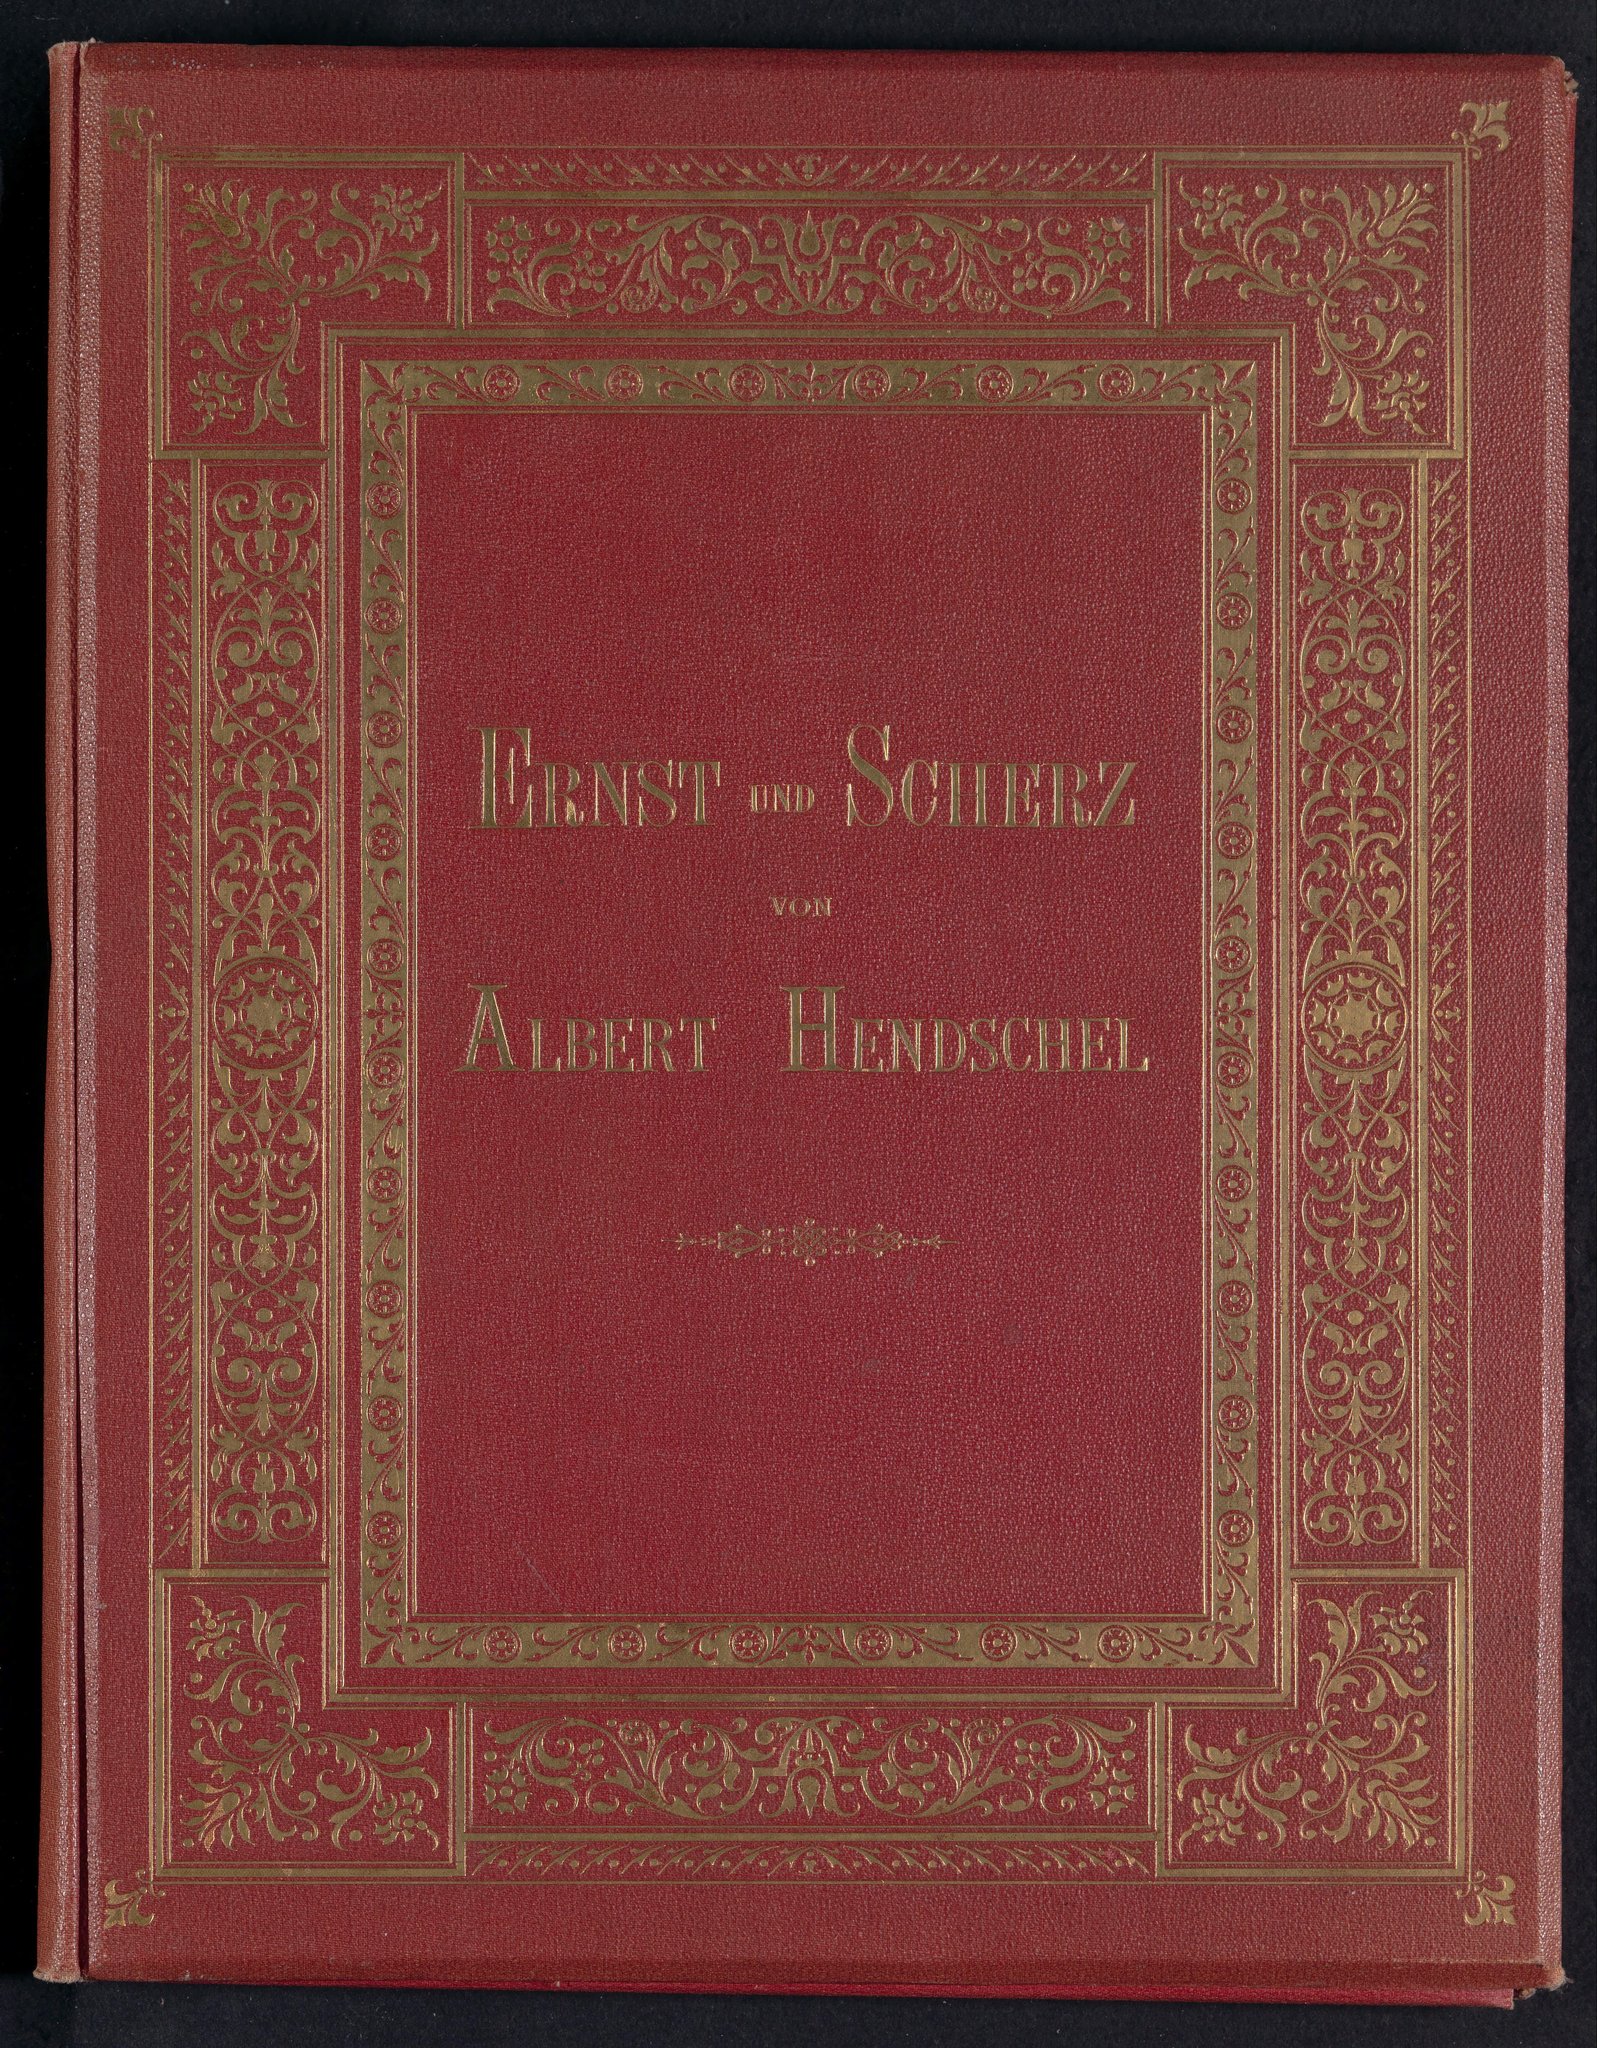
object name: book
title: Ernst und Scherz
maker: albert hendschel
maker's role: draughtsman, painter, print maker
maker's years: 1834-1883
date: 1879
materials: cardboard, linen, paper, photographic support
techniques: albumen print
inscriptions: name: ‘August Osterrieth [...]’